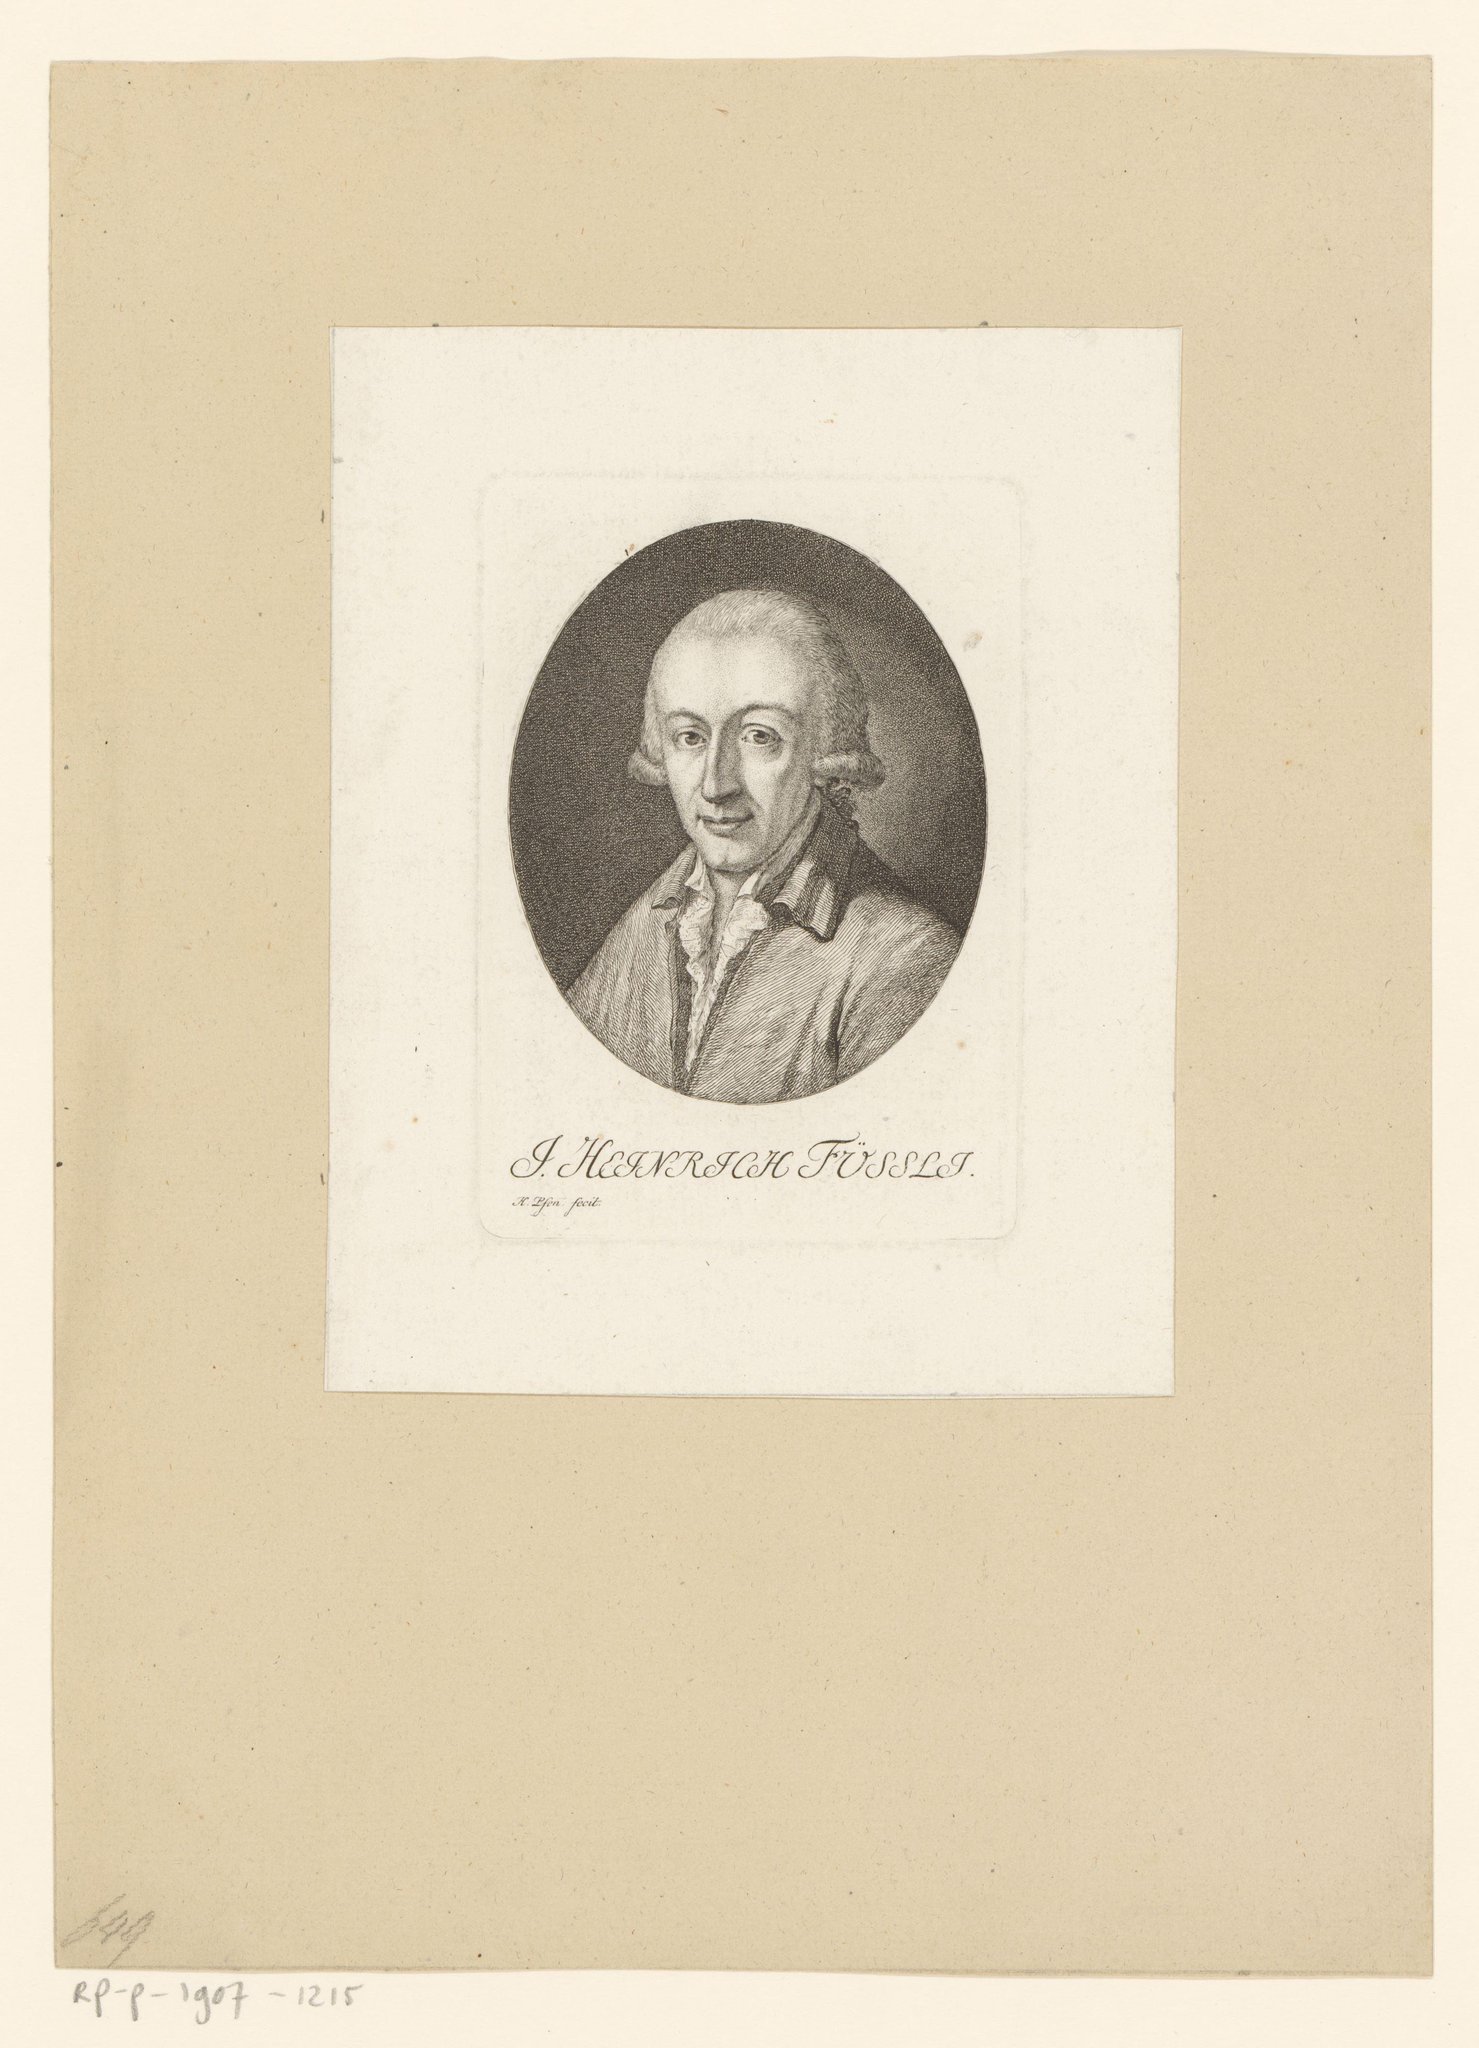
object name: print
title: Portret van Johann Heinrich Füssli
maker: heinrich pfenninger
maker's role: print maker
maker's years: 1749-1815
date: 1759-1815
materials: paper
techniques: etching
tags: print maker, draughtsman, johann heinrich füssli, historical persons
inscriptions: collector's mark: Lugt 2228